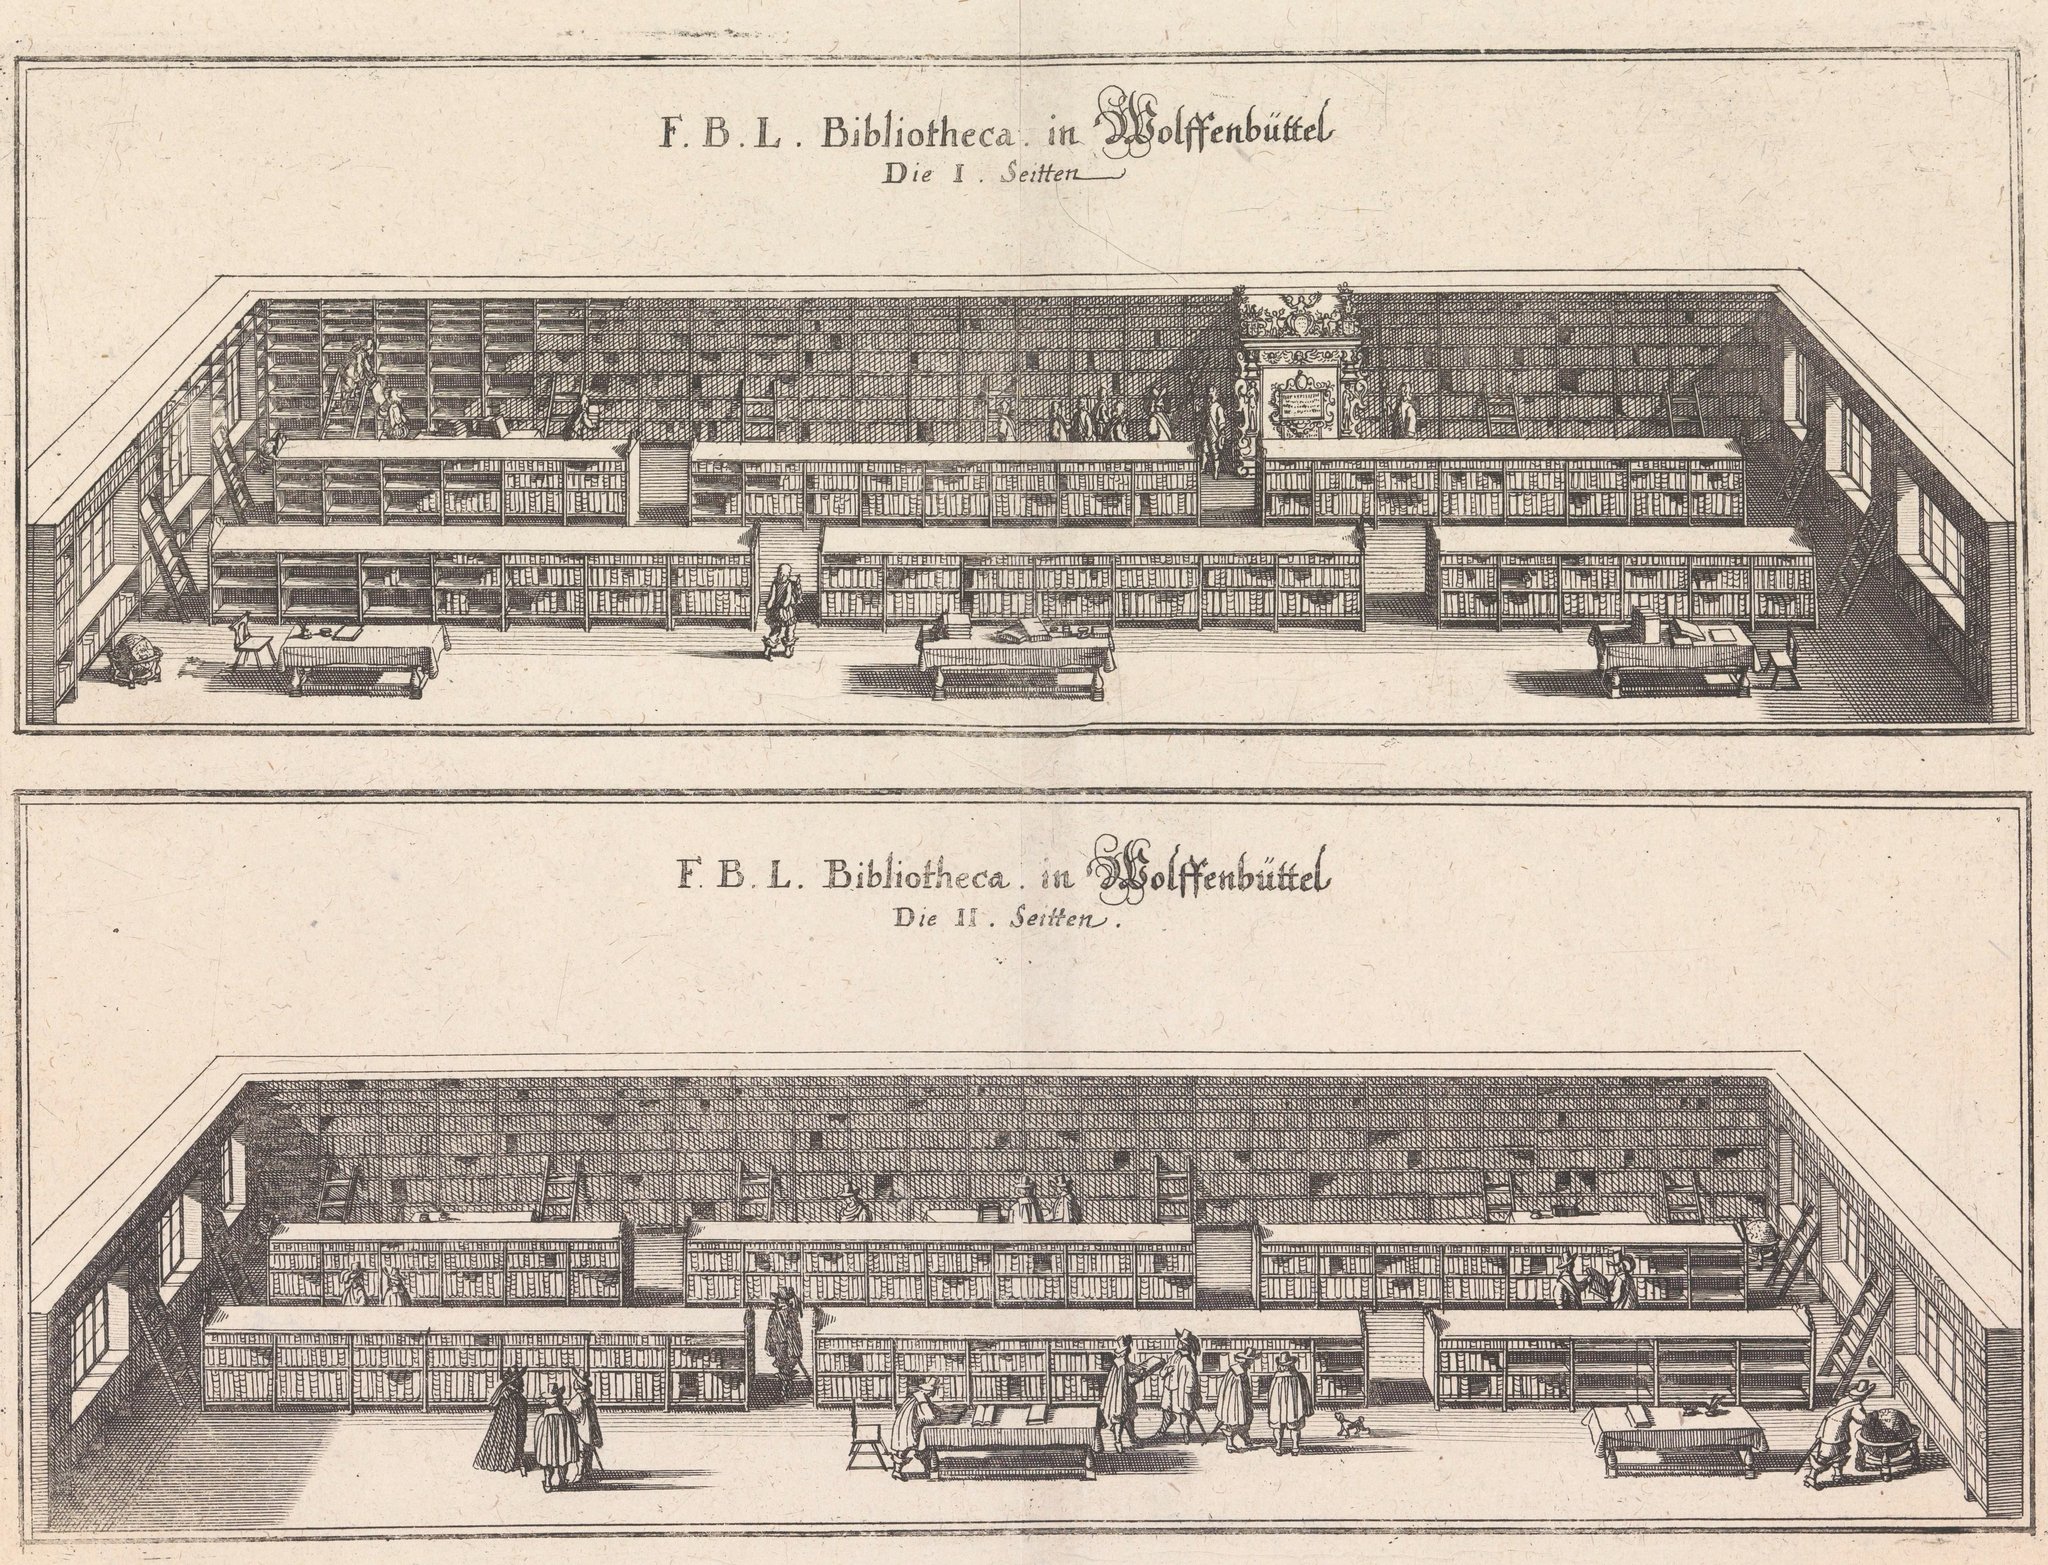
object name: print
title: F.B.L. Bibliotheca in Wolffenbüttel Die I. Seitten / F.B.L. Bibliotheca in Wolffenbüttel Die II. Seitten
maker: caspar merian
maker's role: print maker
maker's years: 1627-1689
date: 1654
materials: paper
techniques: engraving, etching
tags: writing-table, writing-desk, globe, public library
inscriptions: collector's mark: Lugt 4779, collector's mark: Lugt 2228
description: Prent ook gebruikt in: Topographia Germaniae, uitgegeven tussen 1642-1654.